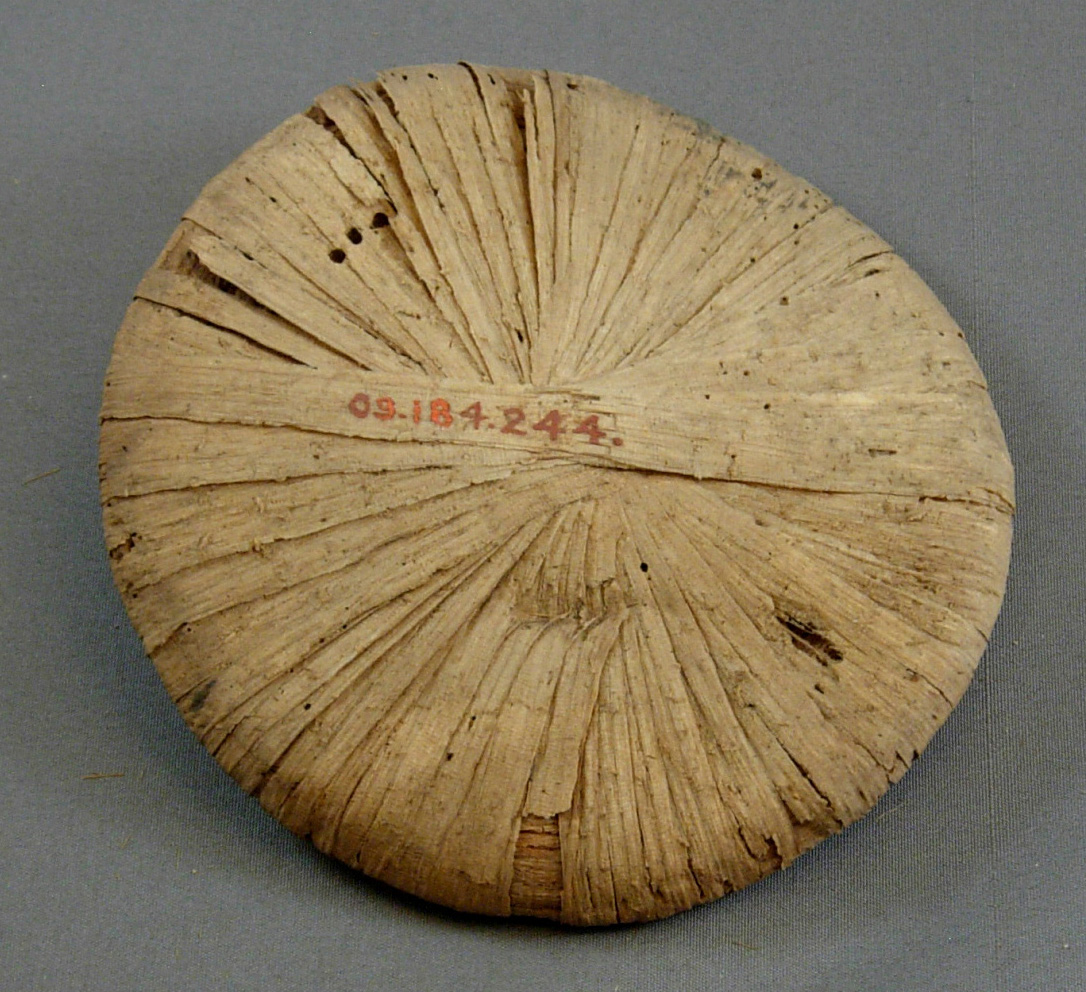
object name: jar lid, papyrus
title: Papyrus Lids from the Embalming Cache of Tutankhamun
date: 1336-1327 BCE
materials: fiber, papyrus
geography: egypt